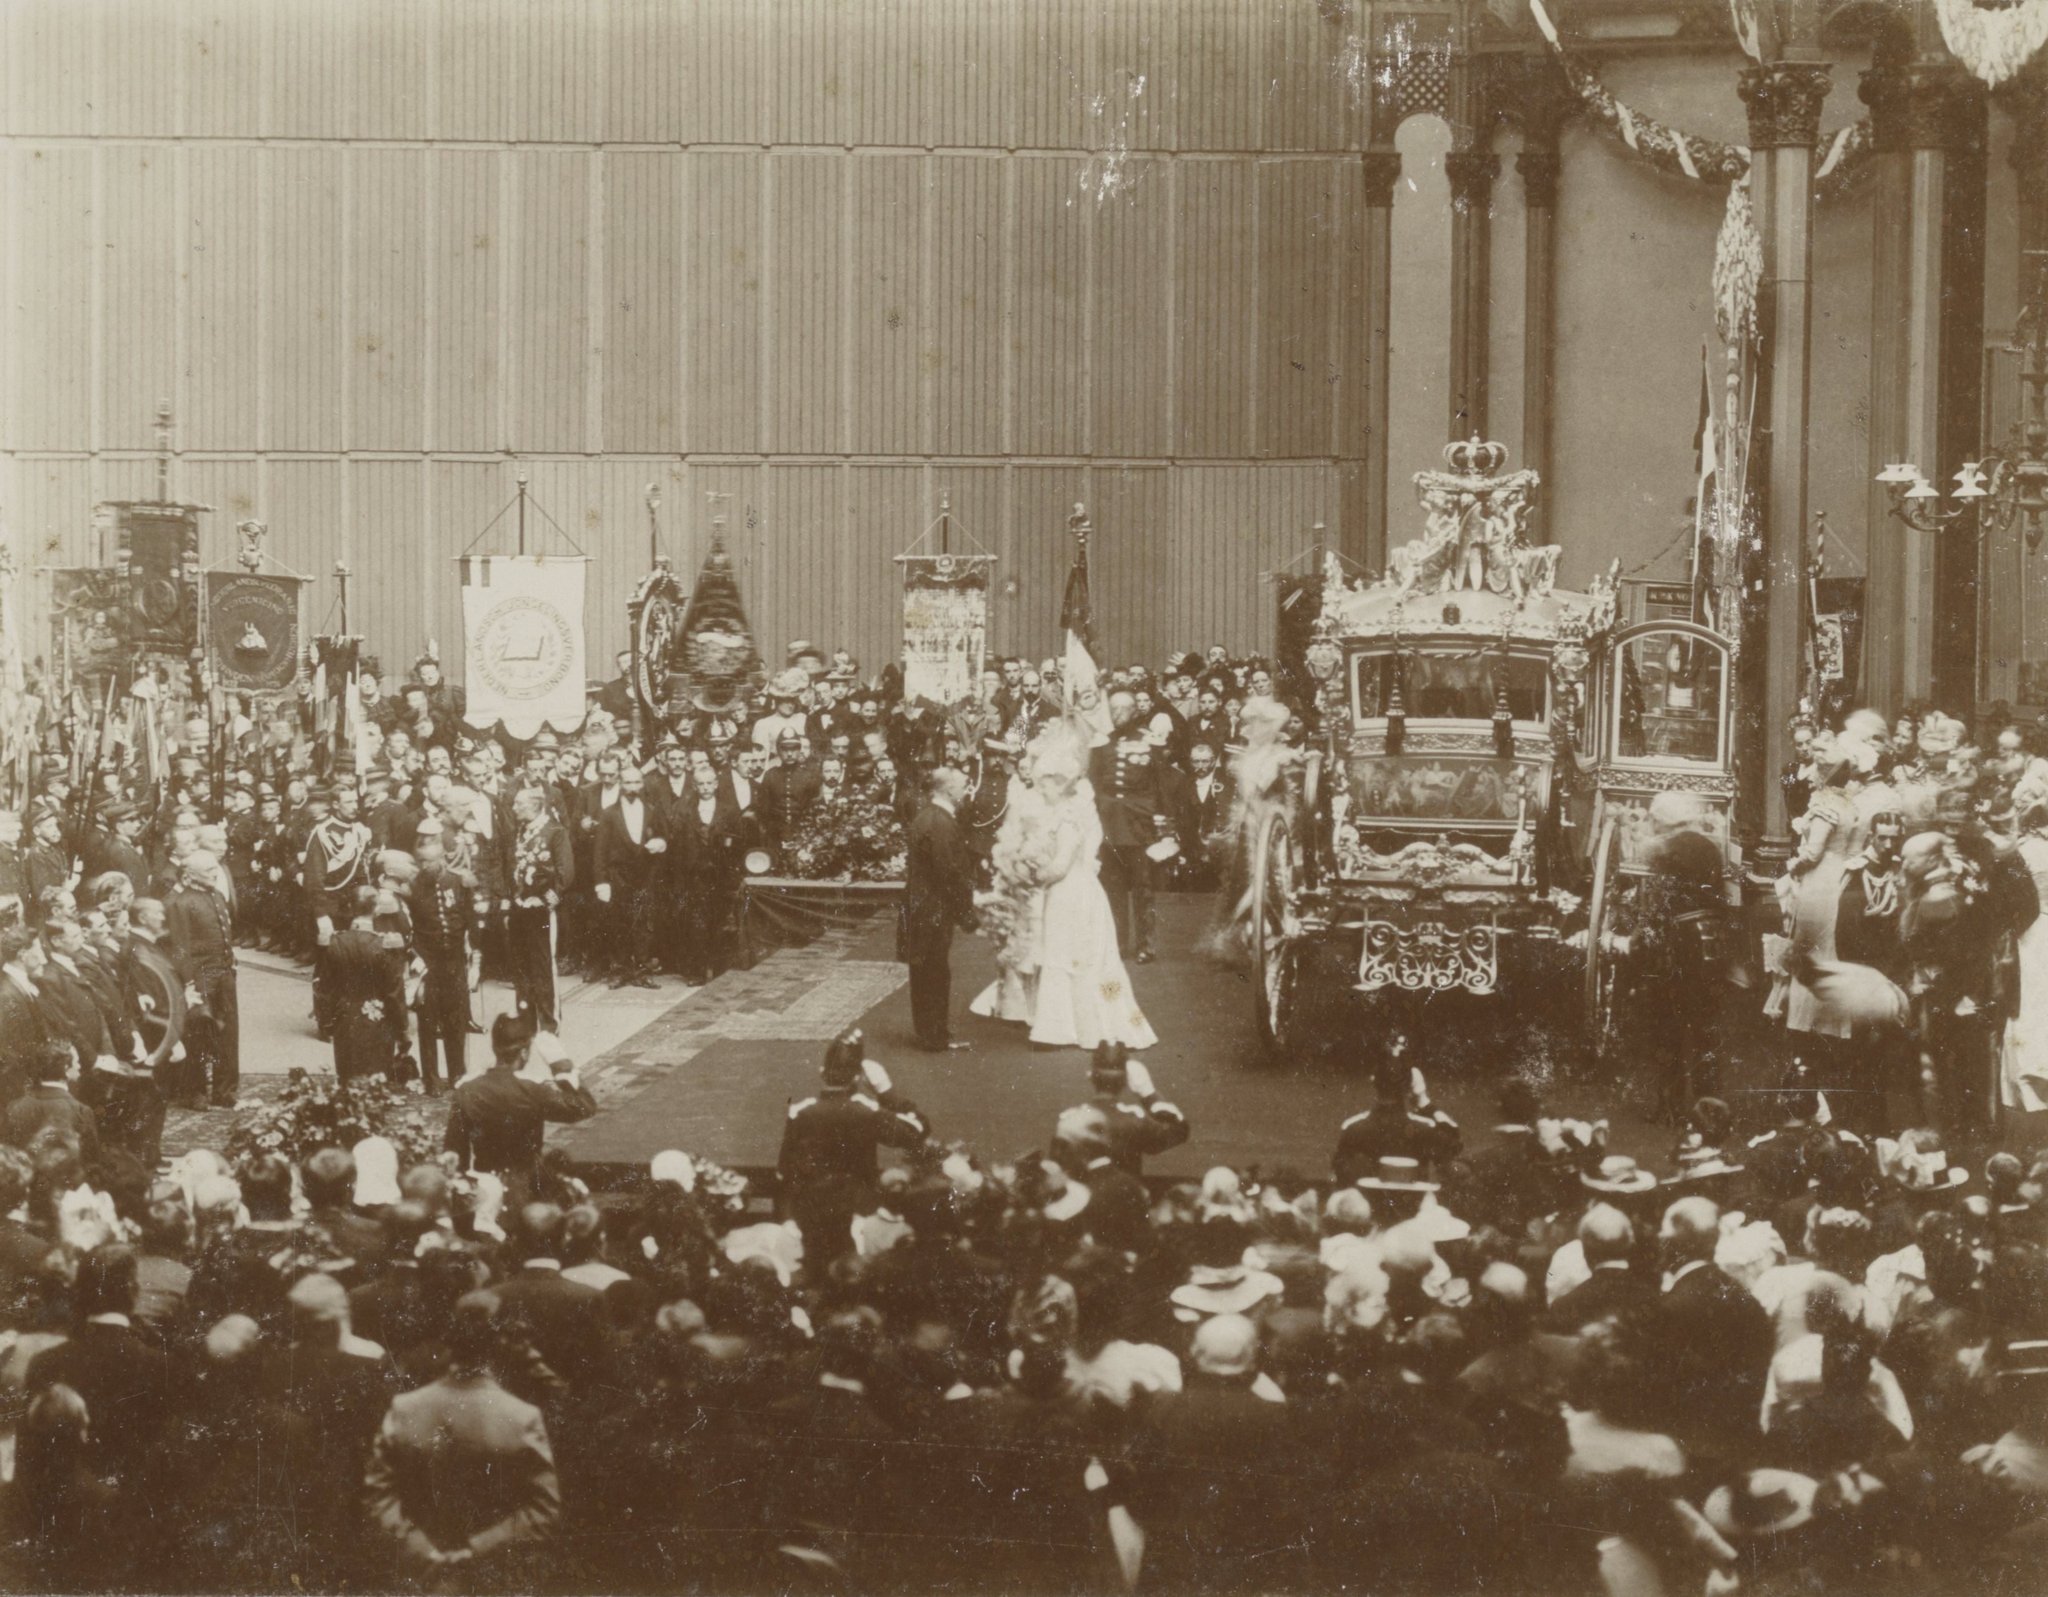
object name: photograph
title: Koningin Wilhelmina ontvangt De Gouden koets als geschenk van de bevolking van Amsterdam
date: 1898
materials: cardboard, paper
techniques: albumen print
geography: amsterdam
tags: the hague, print maker, wilhelmina of the netherlands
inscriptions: name: ‘Sigling & Lukera Amsterdam Jacob van CAmpenstraat 96’